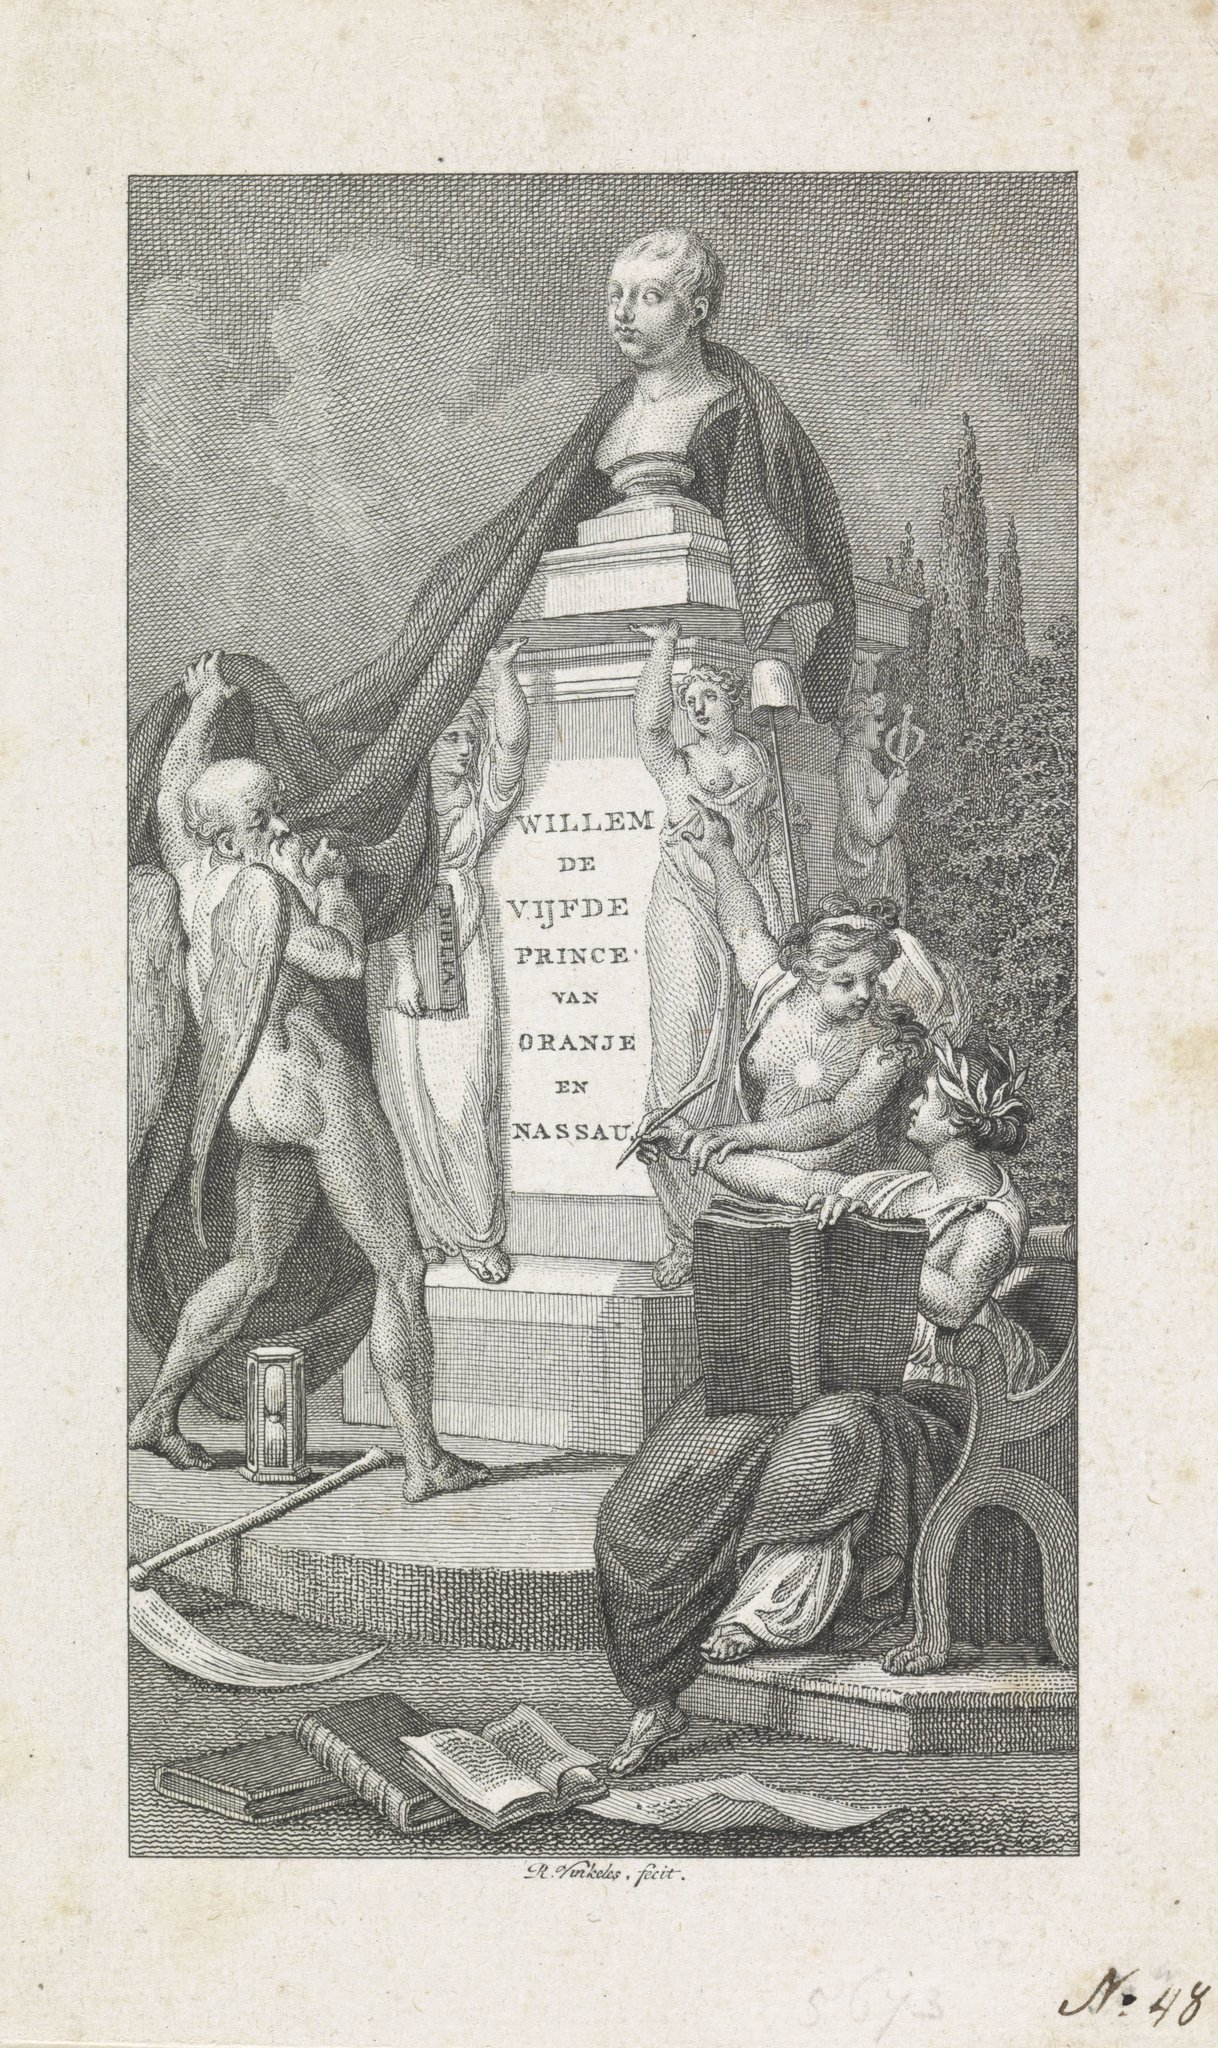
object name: print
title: Tijd onthult een grafmonument voor prins Willem V, 1806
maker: reinier vinkeles (i)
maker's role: draughtsman, print maker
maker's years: 1741-1816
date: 1806-1807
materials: paper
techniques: engraving, etching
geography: netherlands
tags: the hague, william v (prince of orange), 'historia'; 'historia' (ripa), grave-building, monumental tomb, father time, man with wings and scythe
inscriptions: collector's mark: Lugt 2228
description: Allegorisch grafmonument voor prins Willem V, overleden op 9 april 1806. Vader Tijd onthult een monument voor de overleden prins. De schrijvende Historie wordt rechts door de Waarheid op het monument gewezen.